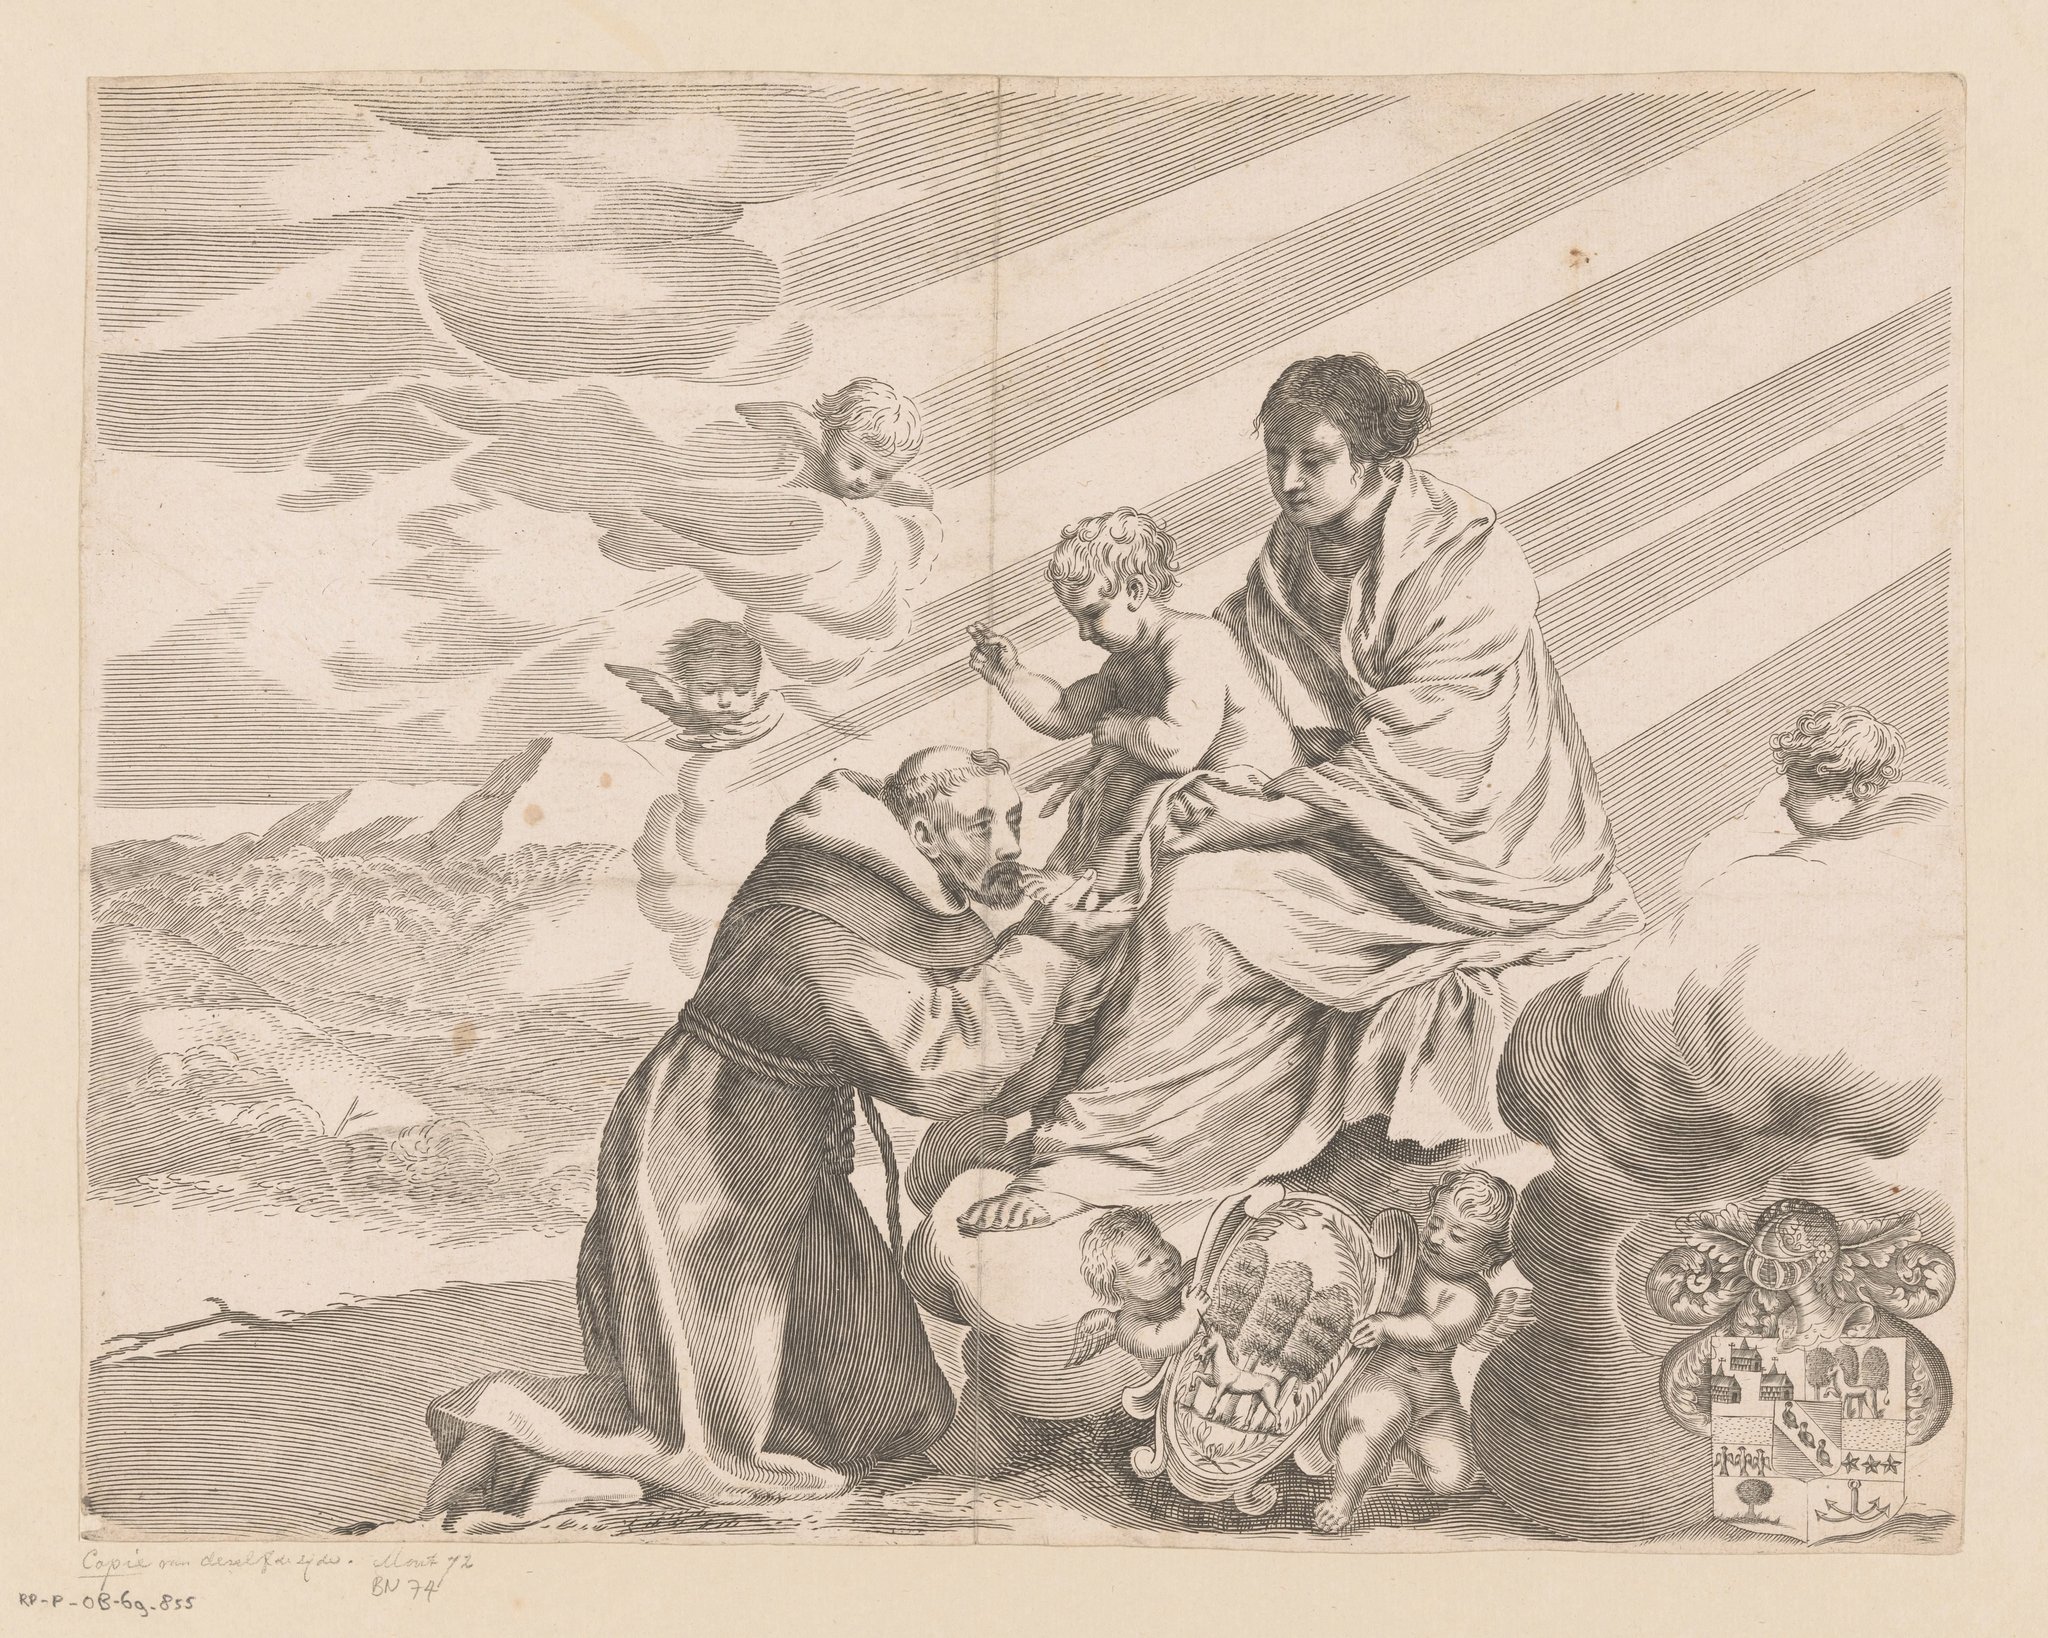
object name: print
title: H. Franciscus van Assissi geknield voor Maria met Kind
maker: Anonymous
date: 1608-1750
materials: paper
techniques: engraving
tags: madonna: i.e. mary with the christ-child, unicorn, founder of the order of friars minor (franciscans), francis(cus) of assisi; possible attributes: book, crucifix, lily, skull, stigmata, armorial bearing, heraldry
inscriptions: collector's mark: Lugt 240